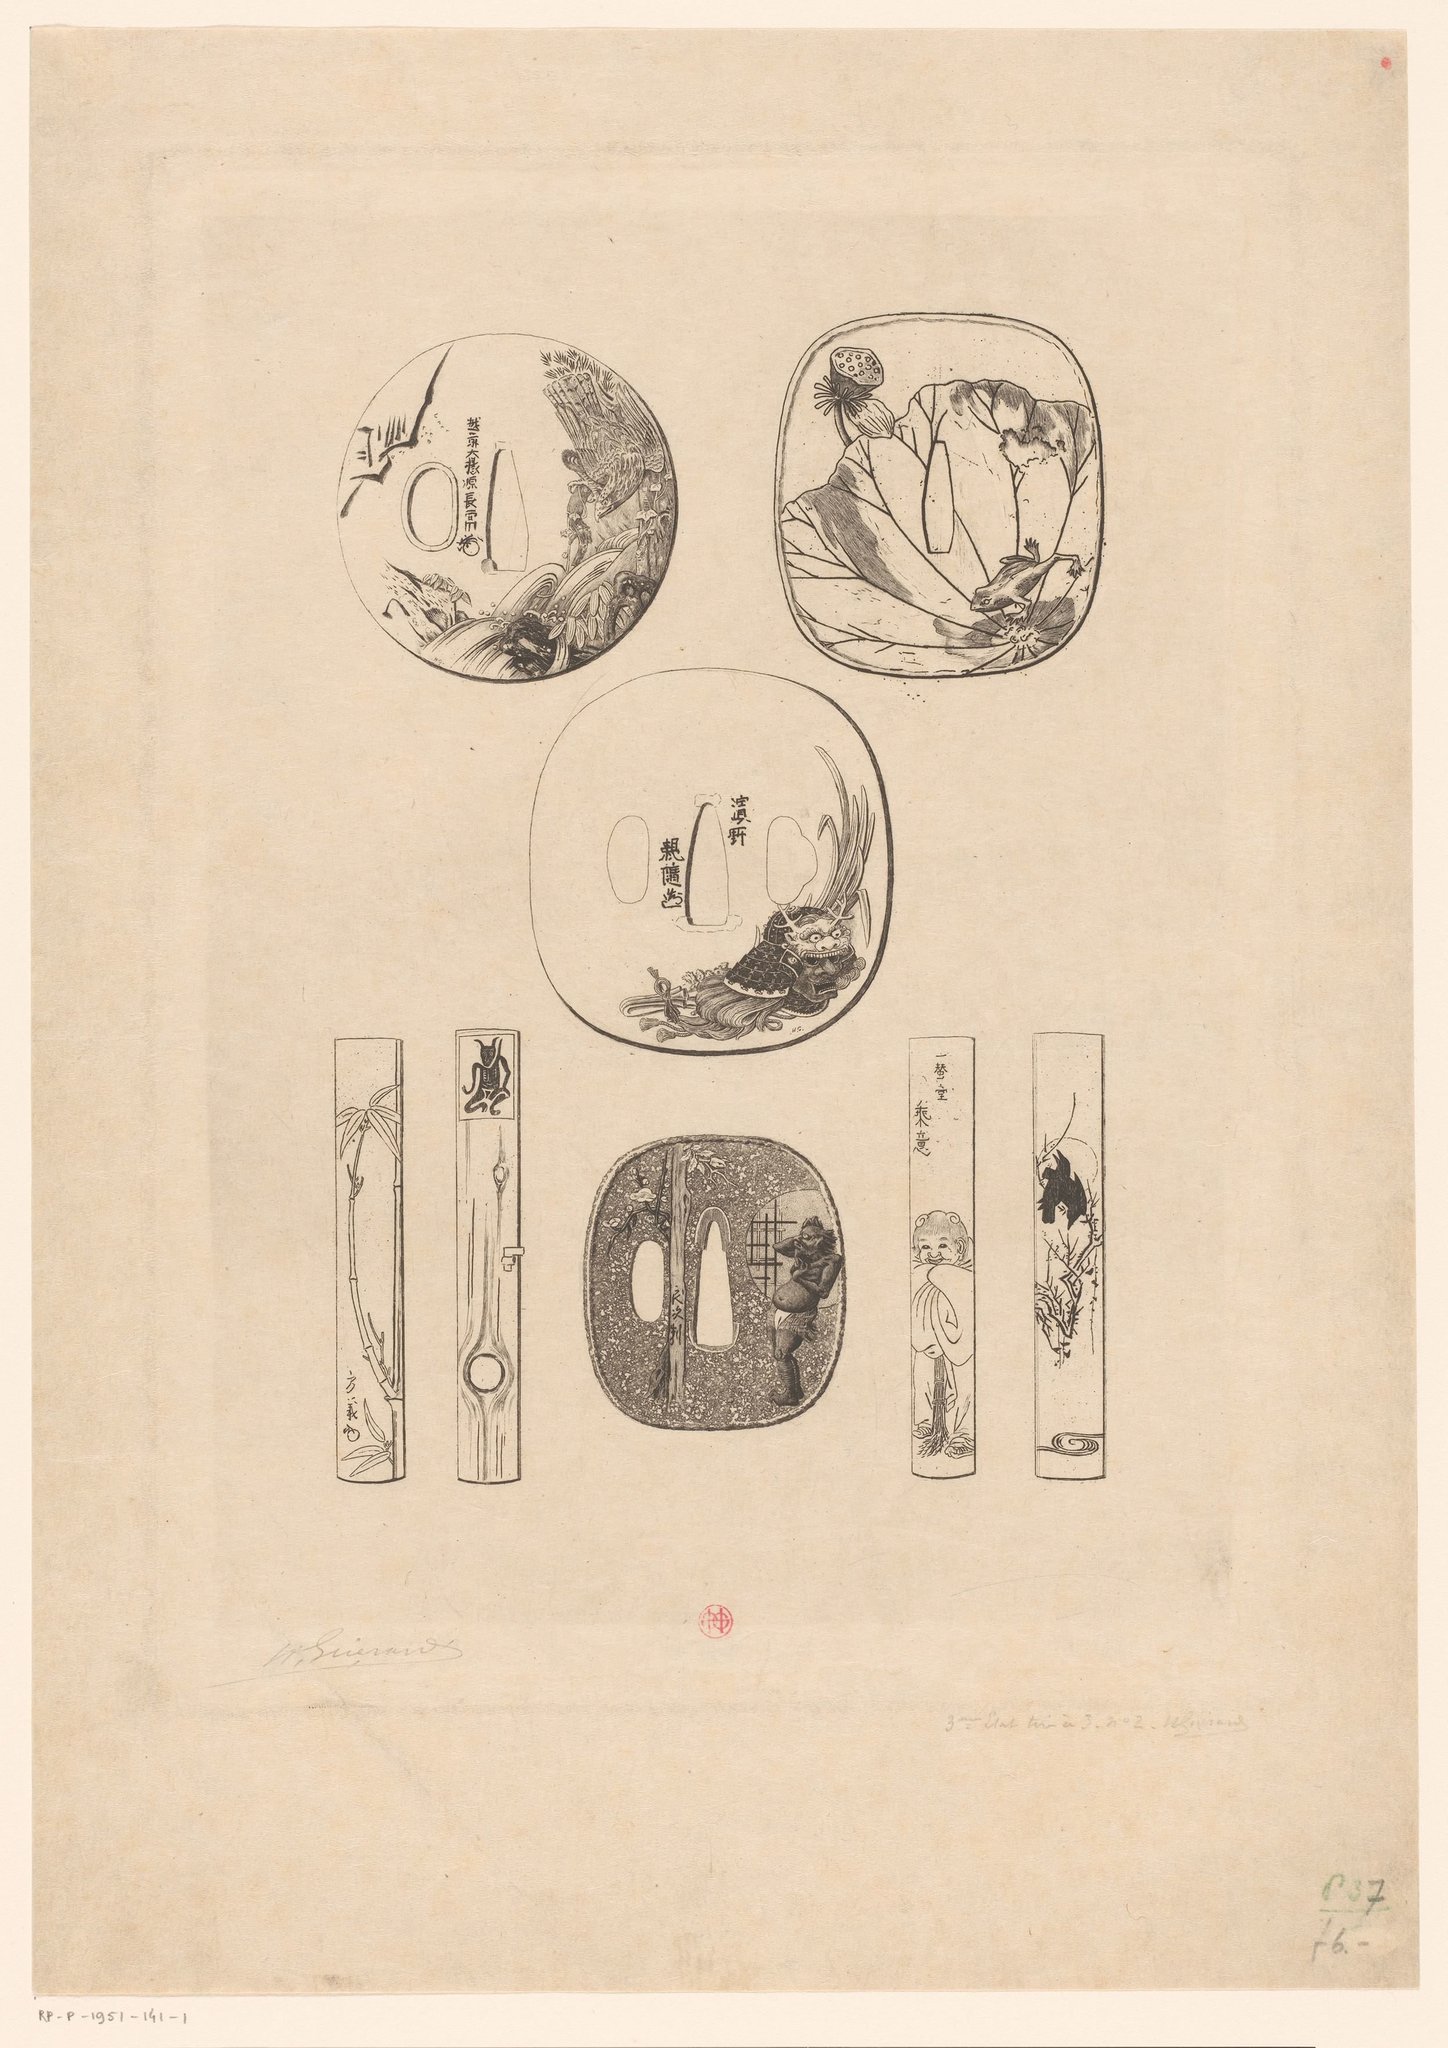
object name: print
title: Japanse gespen met verschillende motieven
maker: henri charles guérard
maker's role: print maker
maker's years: 1846-1897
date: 1856-1897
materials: paper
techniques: aquatint, etching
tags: tailless amphibians: frog, buckle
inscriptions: collector's mark: Lugt 2228, annotation: ‘3ieme Etat tiré à 3. No. 2. Guérard’, stamp: Lugt 1157